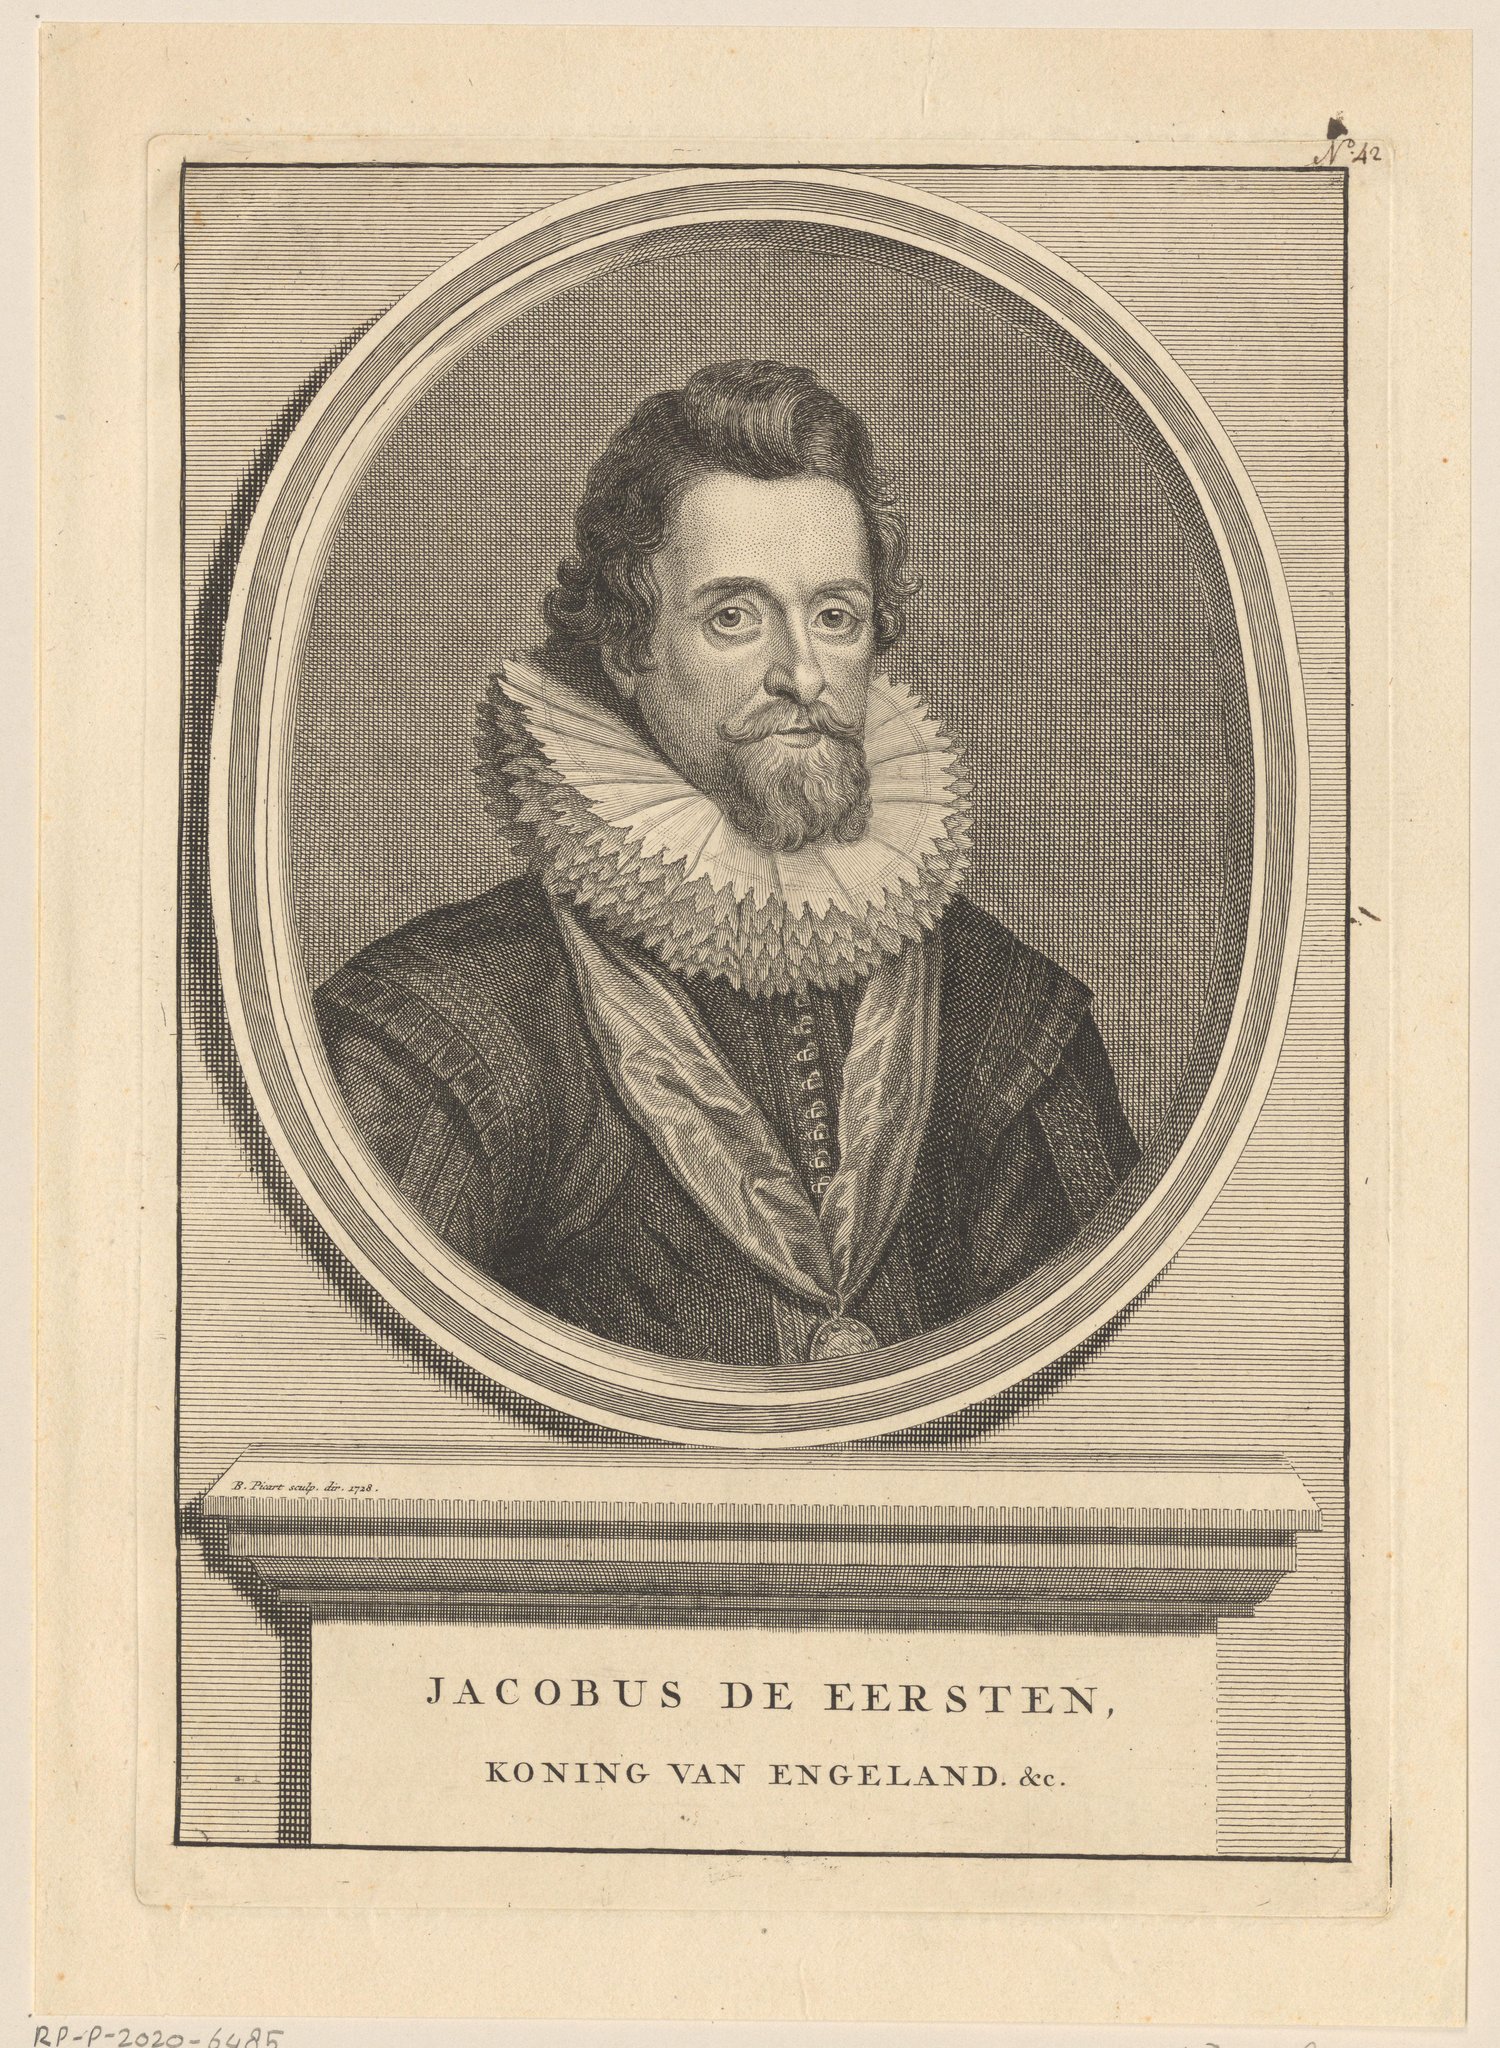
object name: print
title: Portret van Jacobus I, koning van Engeland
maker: bernard picart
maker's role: draughtsman, print maker, publisher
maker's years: 1673-1733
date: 1728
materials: paper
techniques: engraving, etching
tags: jacobus i (koning van engeland), historical persons, king